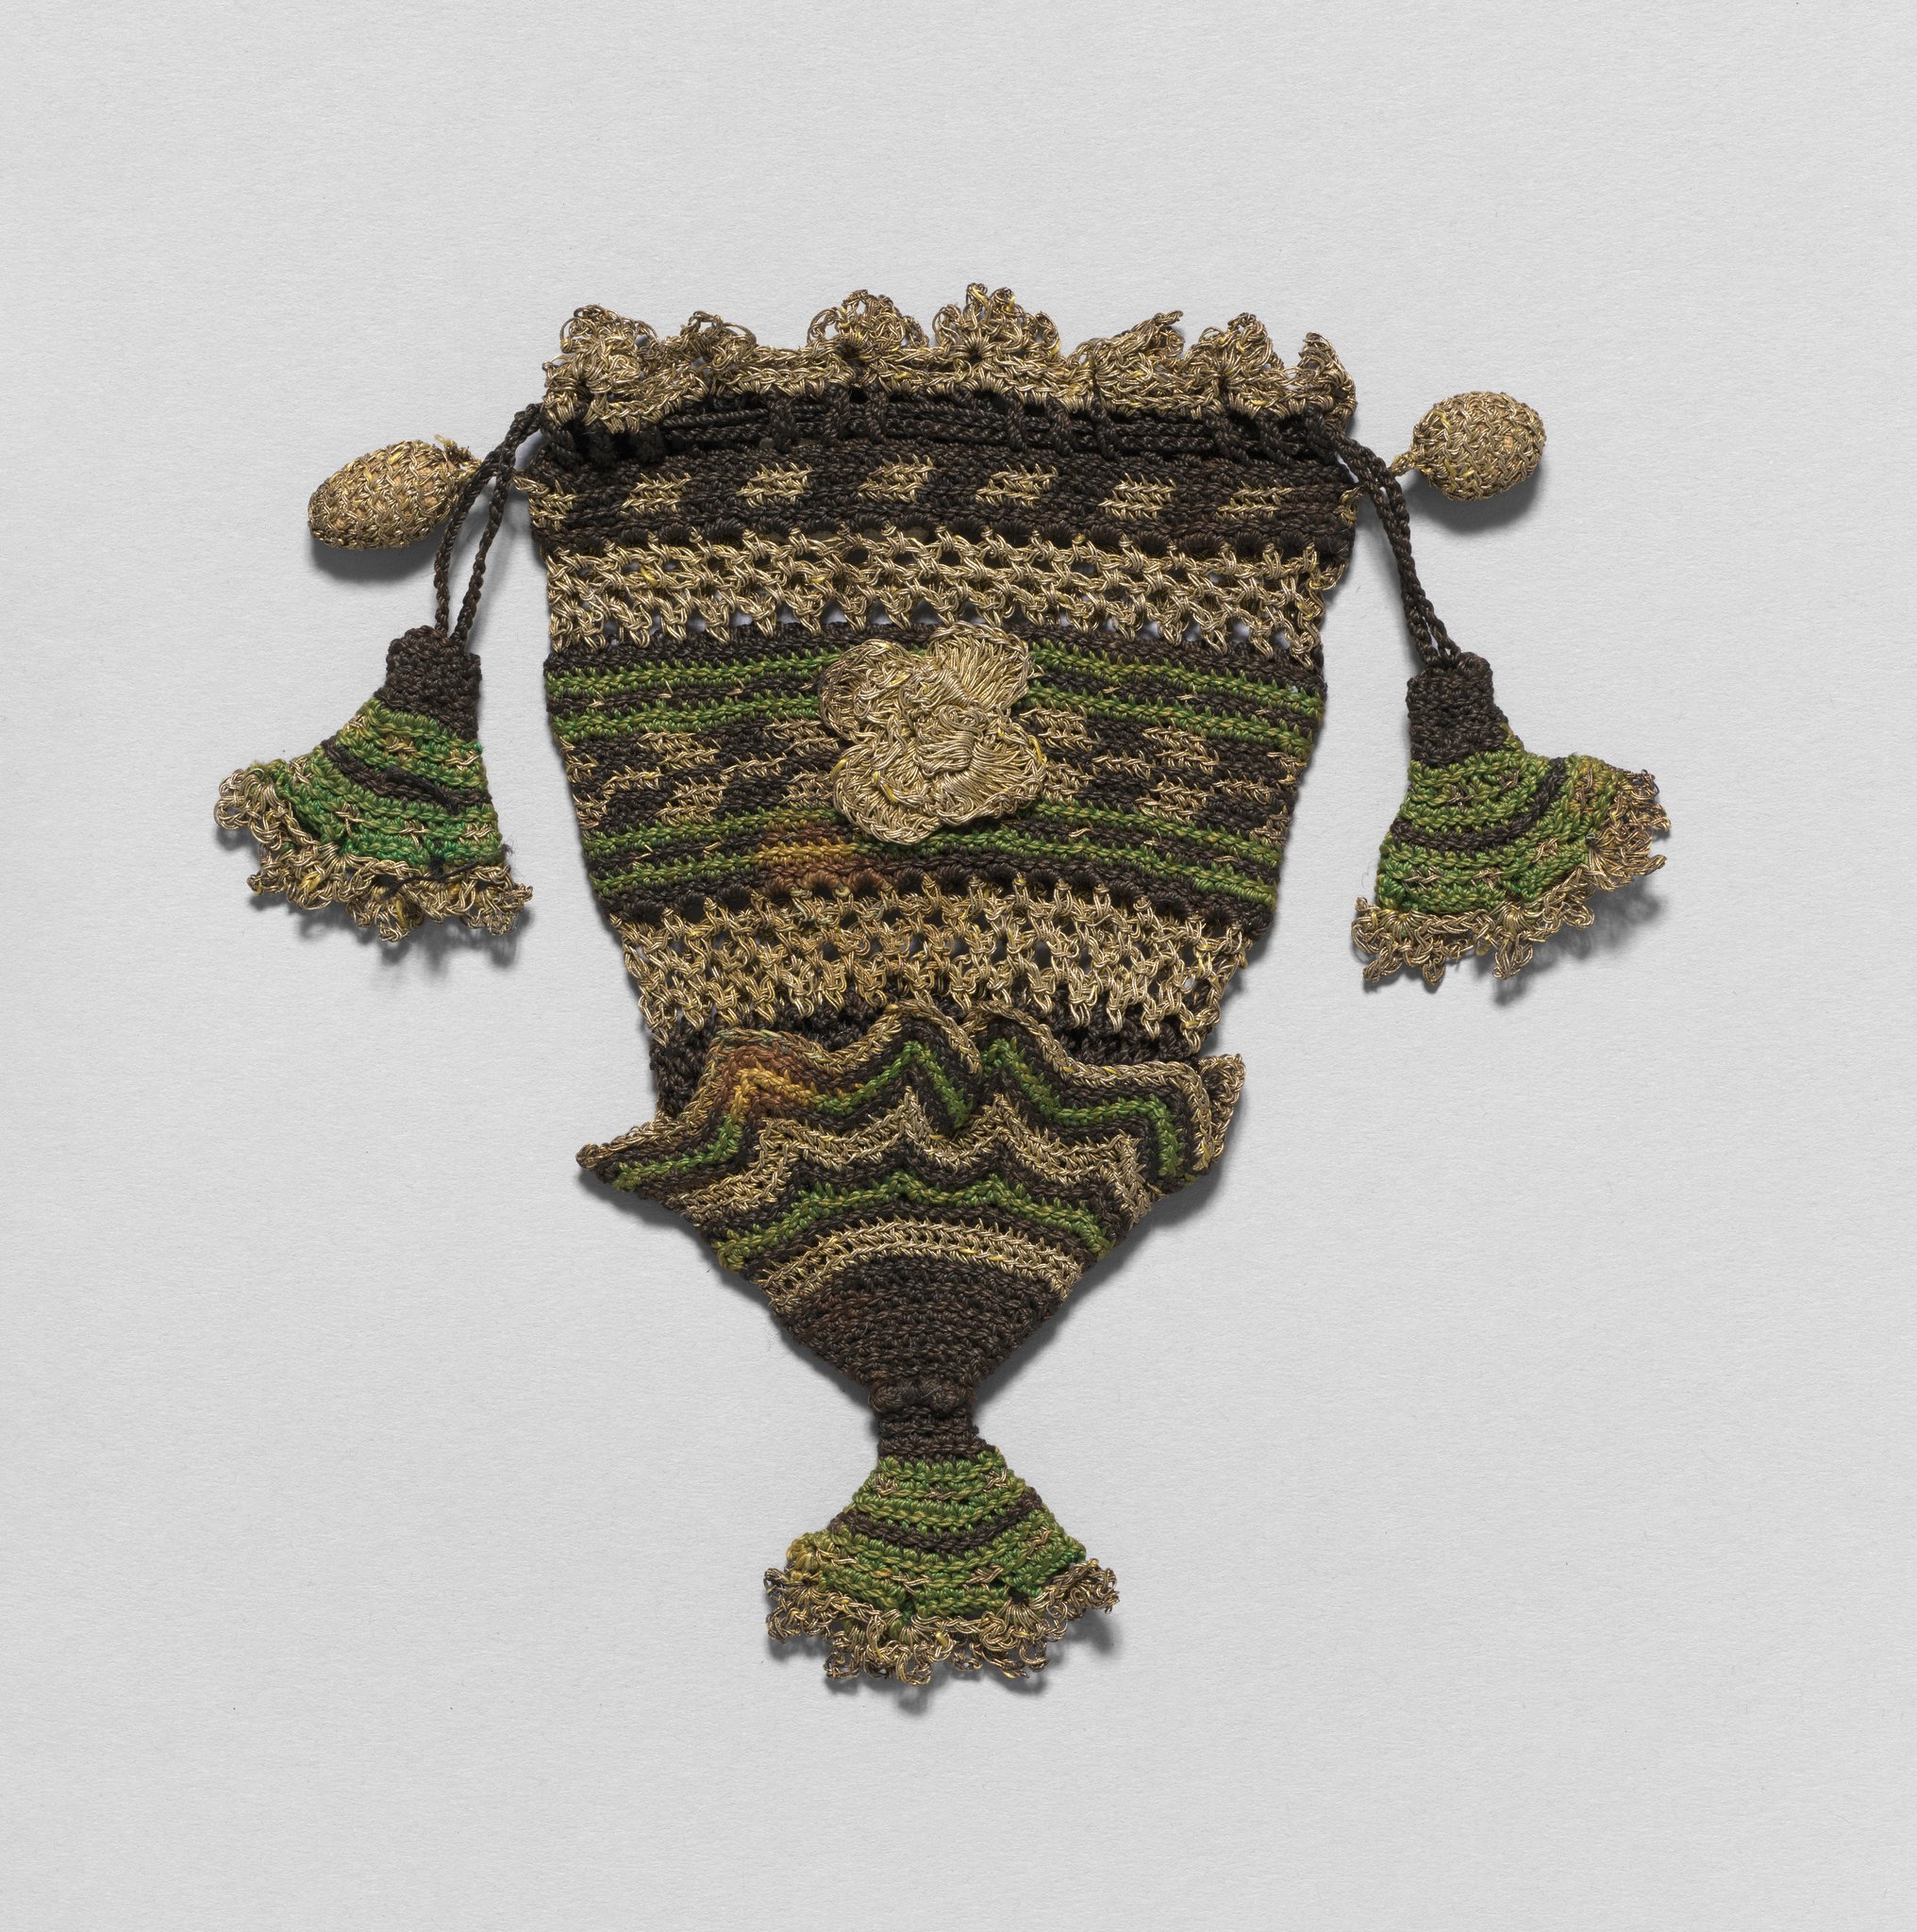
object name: bag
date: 1850-1860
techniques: crochet